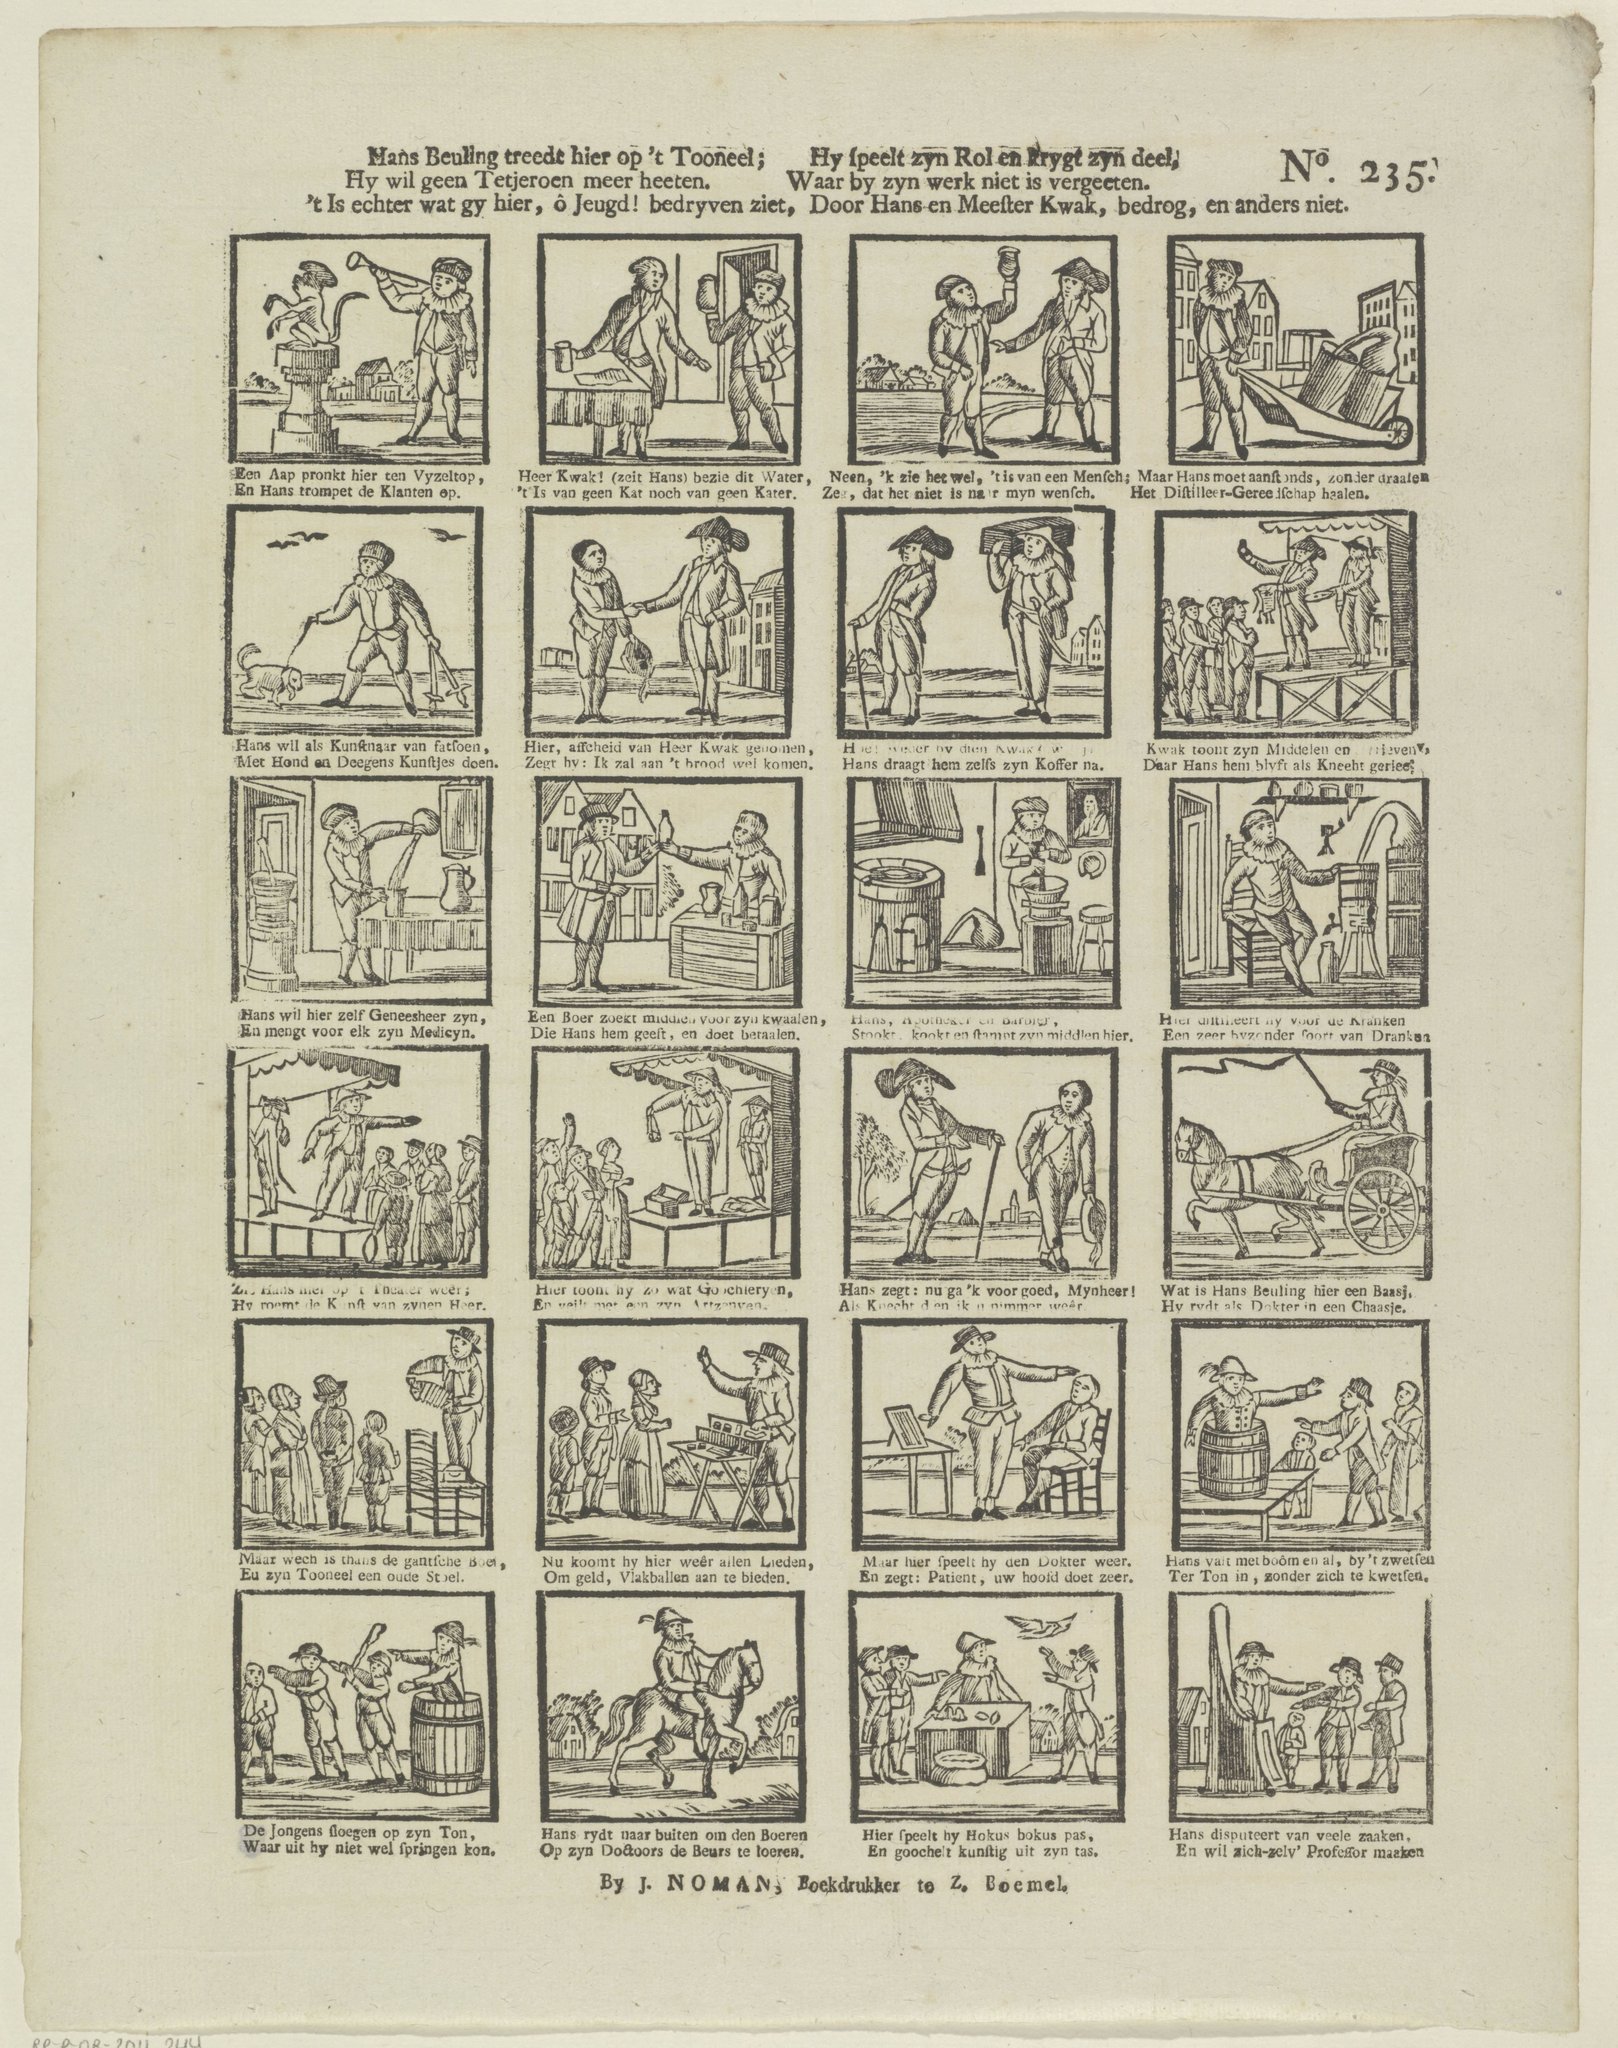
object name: print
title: Hans Beuling treedt hier op 't toneel; / Hy wil geen Tetjeroen meer heeten [(...)]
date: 1806-1830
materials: paper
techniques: letterpress printing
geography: netherlands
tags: quack, charlatan, mountebank, 'saltimbanco', passenger carriage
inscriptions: collector's mark: Lugt 2760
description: Blad met 24 voorstellingen over het leven van de kwakzalver en grappenmaker Hans Beuling. Onder elke afbeelding een tweeregelig vers. Genummerd rechtsboven: No. 235.